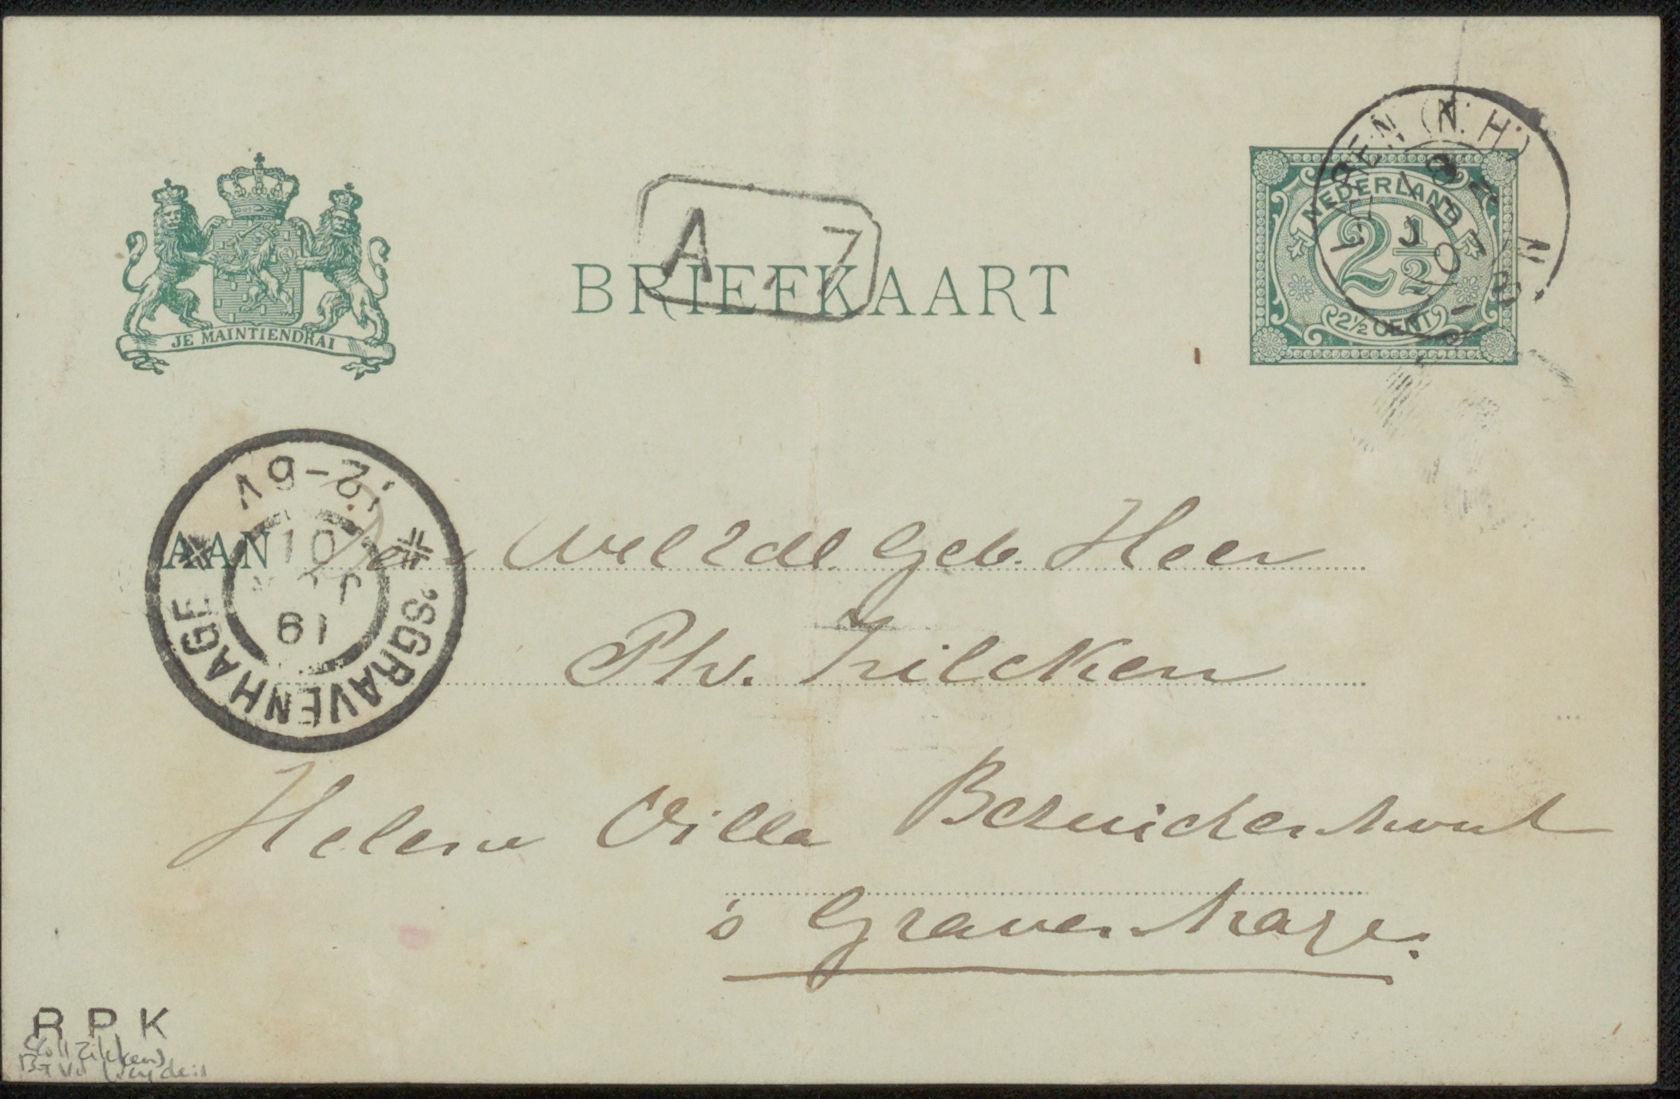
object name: postcard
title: Briefkaart aan Philip Zilcken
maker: marie j. van der weyde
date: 1901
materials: cardboard, ink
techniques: pen, writing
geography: laren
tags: the hague, draughtsman, philip zilcken, illustration ~ printed matter, book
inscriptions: collector's mark: ‘RPK’